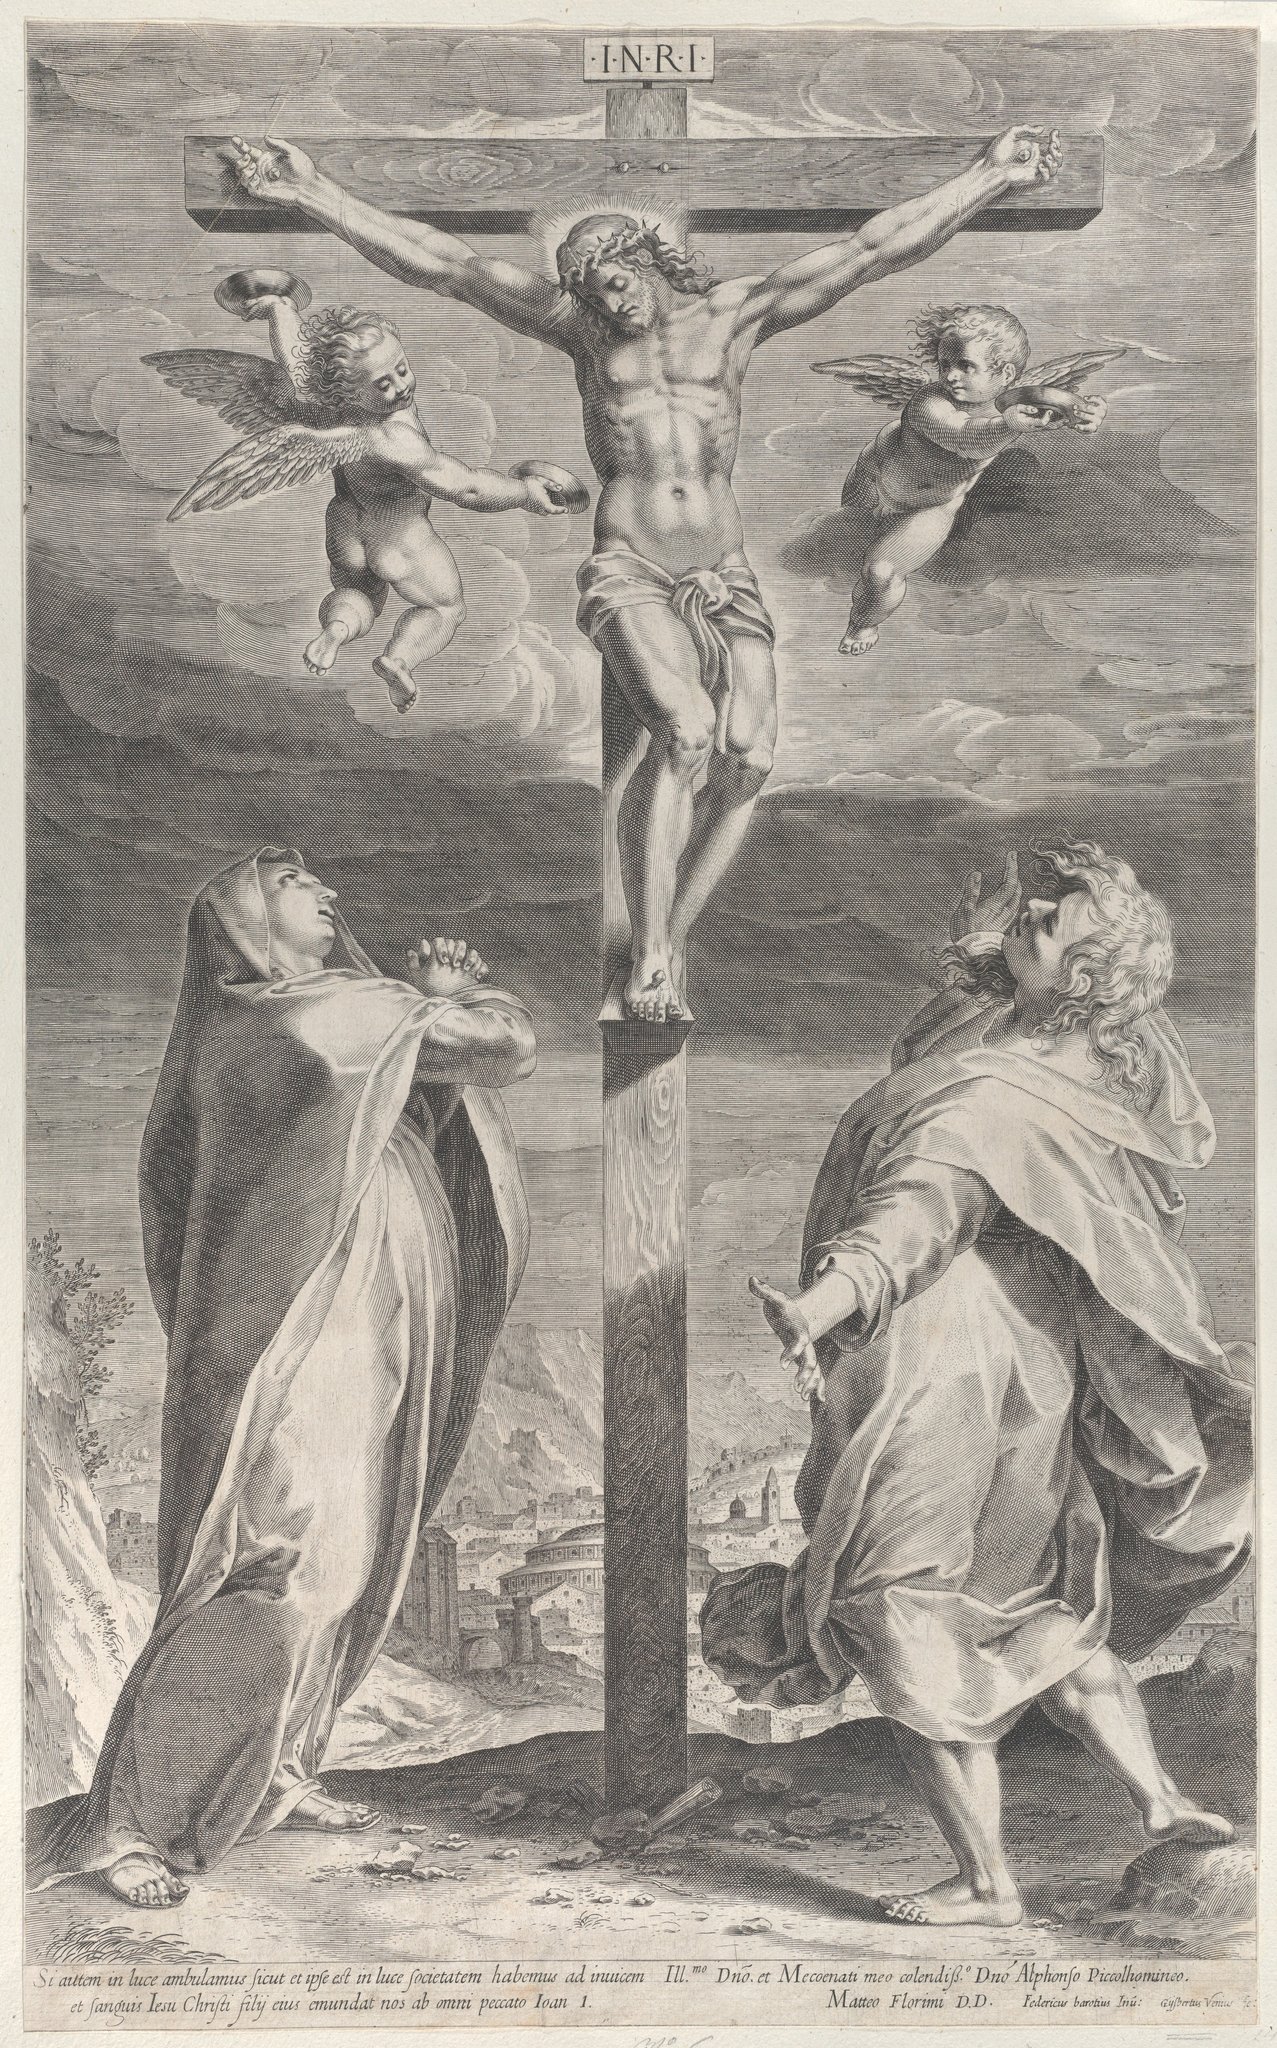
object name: print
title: Crucifixion with the Virgin Mary and Saint John the Evangelist, angels overhead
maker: gijsbert van veen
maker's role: artist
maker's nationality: netherlandish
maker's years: 1562-1628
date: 1593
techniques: engraving